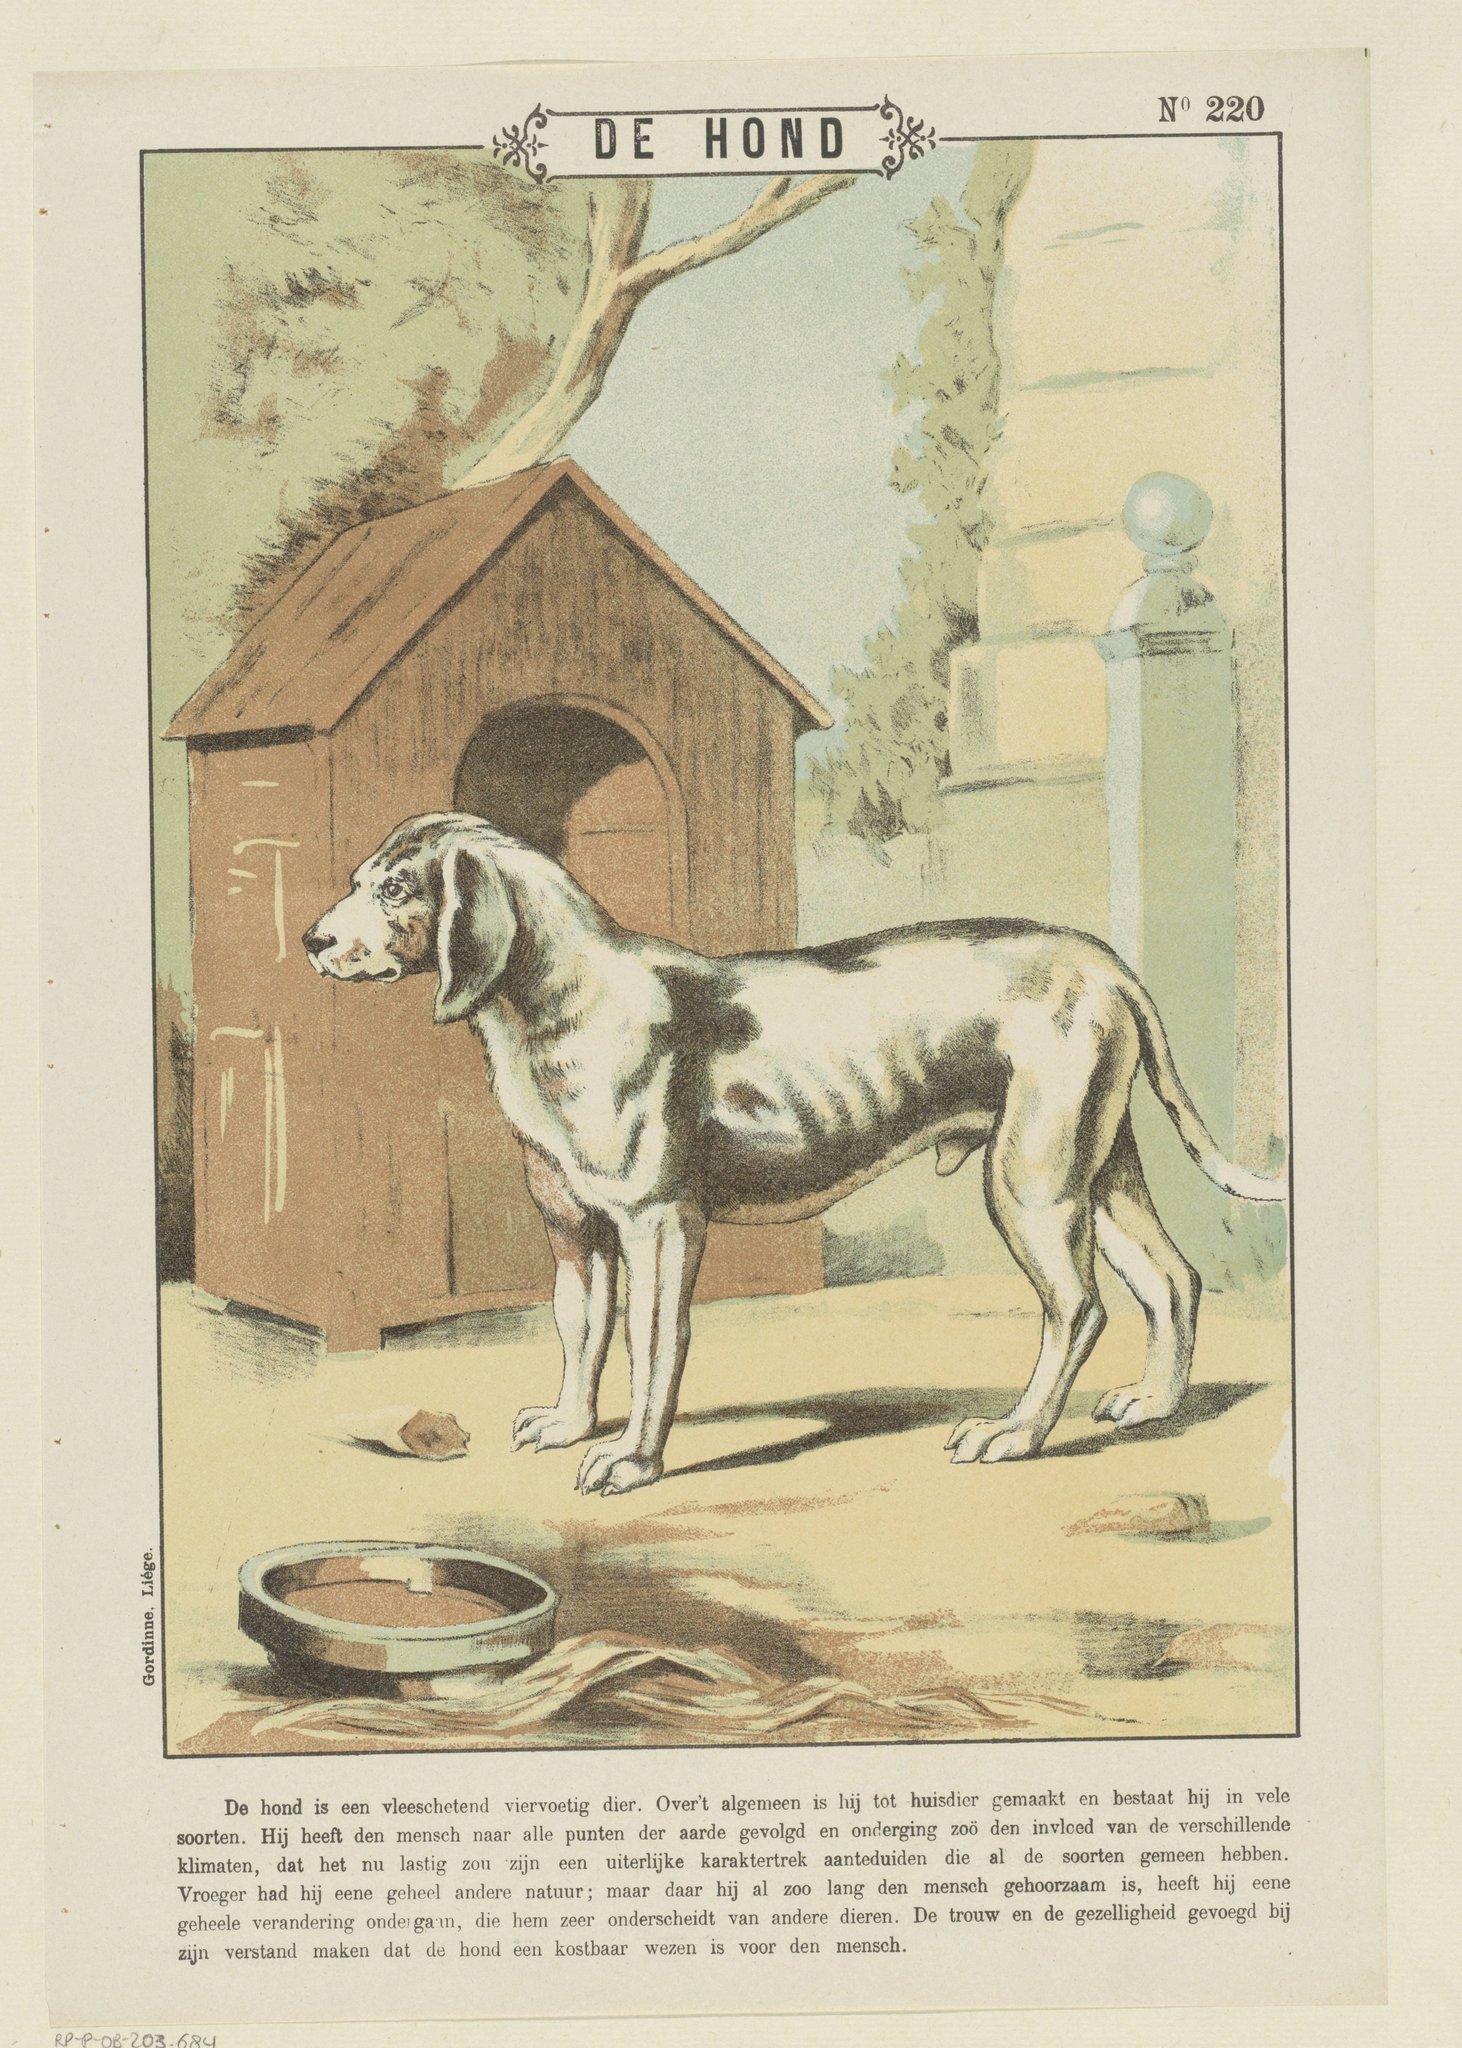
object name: popular print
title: De hond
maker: Anonymous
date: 1894-1959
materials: paper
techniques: lithograph, letterpress printing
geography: liège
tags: dog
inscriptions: collector's mark: Lugt 2760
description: Blad met een grote voorstelling van een hond voor een hondenhok. In de ondermarge een onderschrift. Genummerd rechtsboven: No 220.